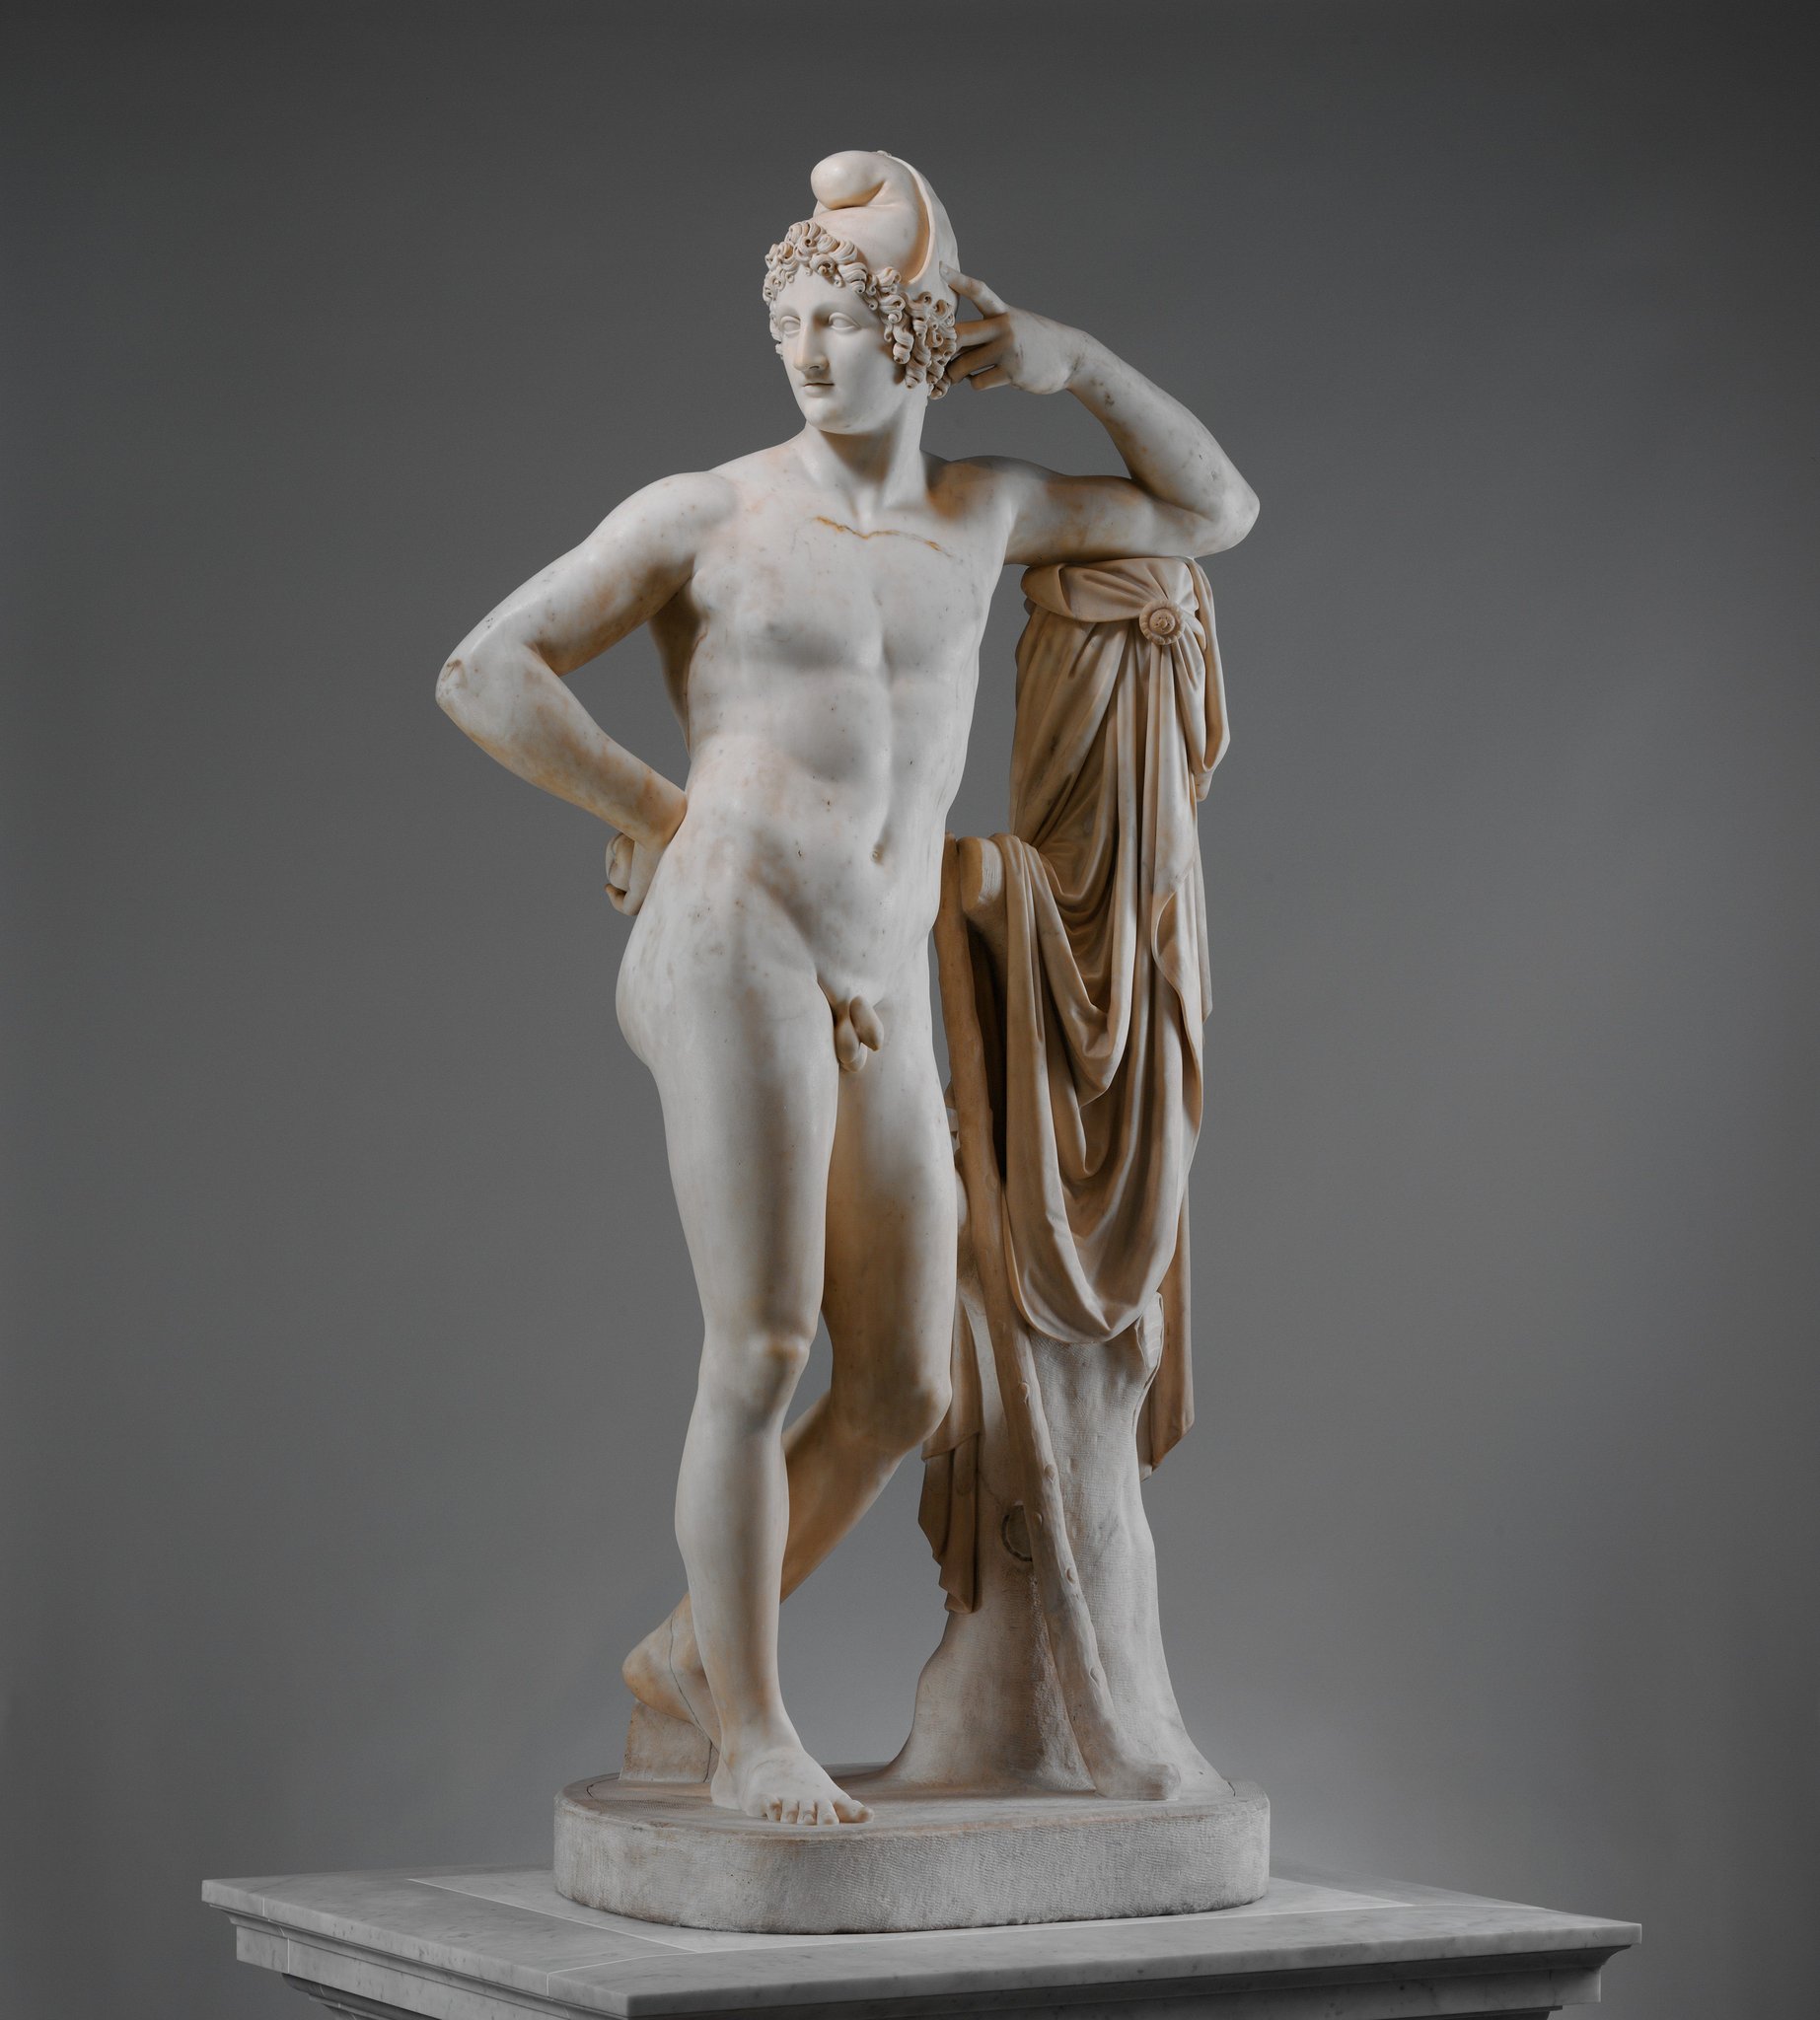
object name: statue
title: Paris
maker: antonio canova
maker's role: artist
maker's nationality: italian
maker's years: 1757-1822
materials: marble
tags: male nudes,paris